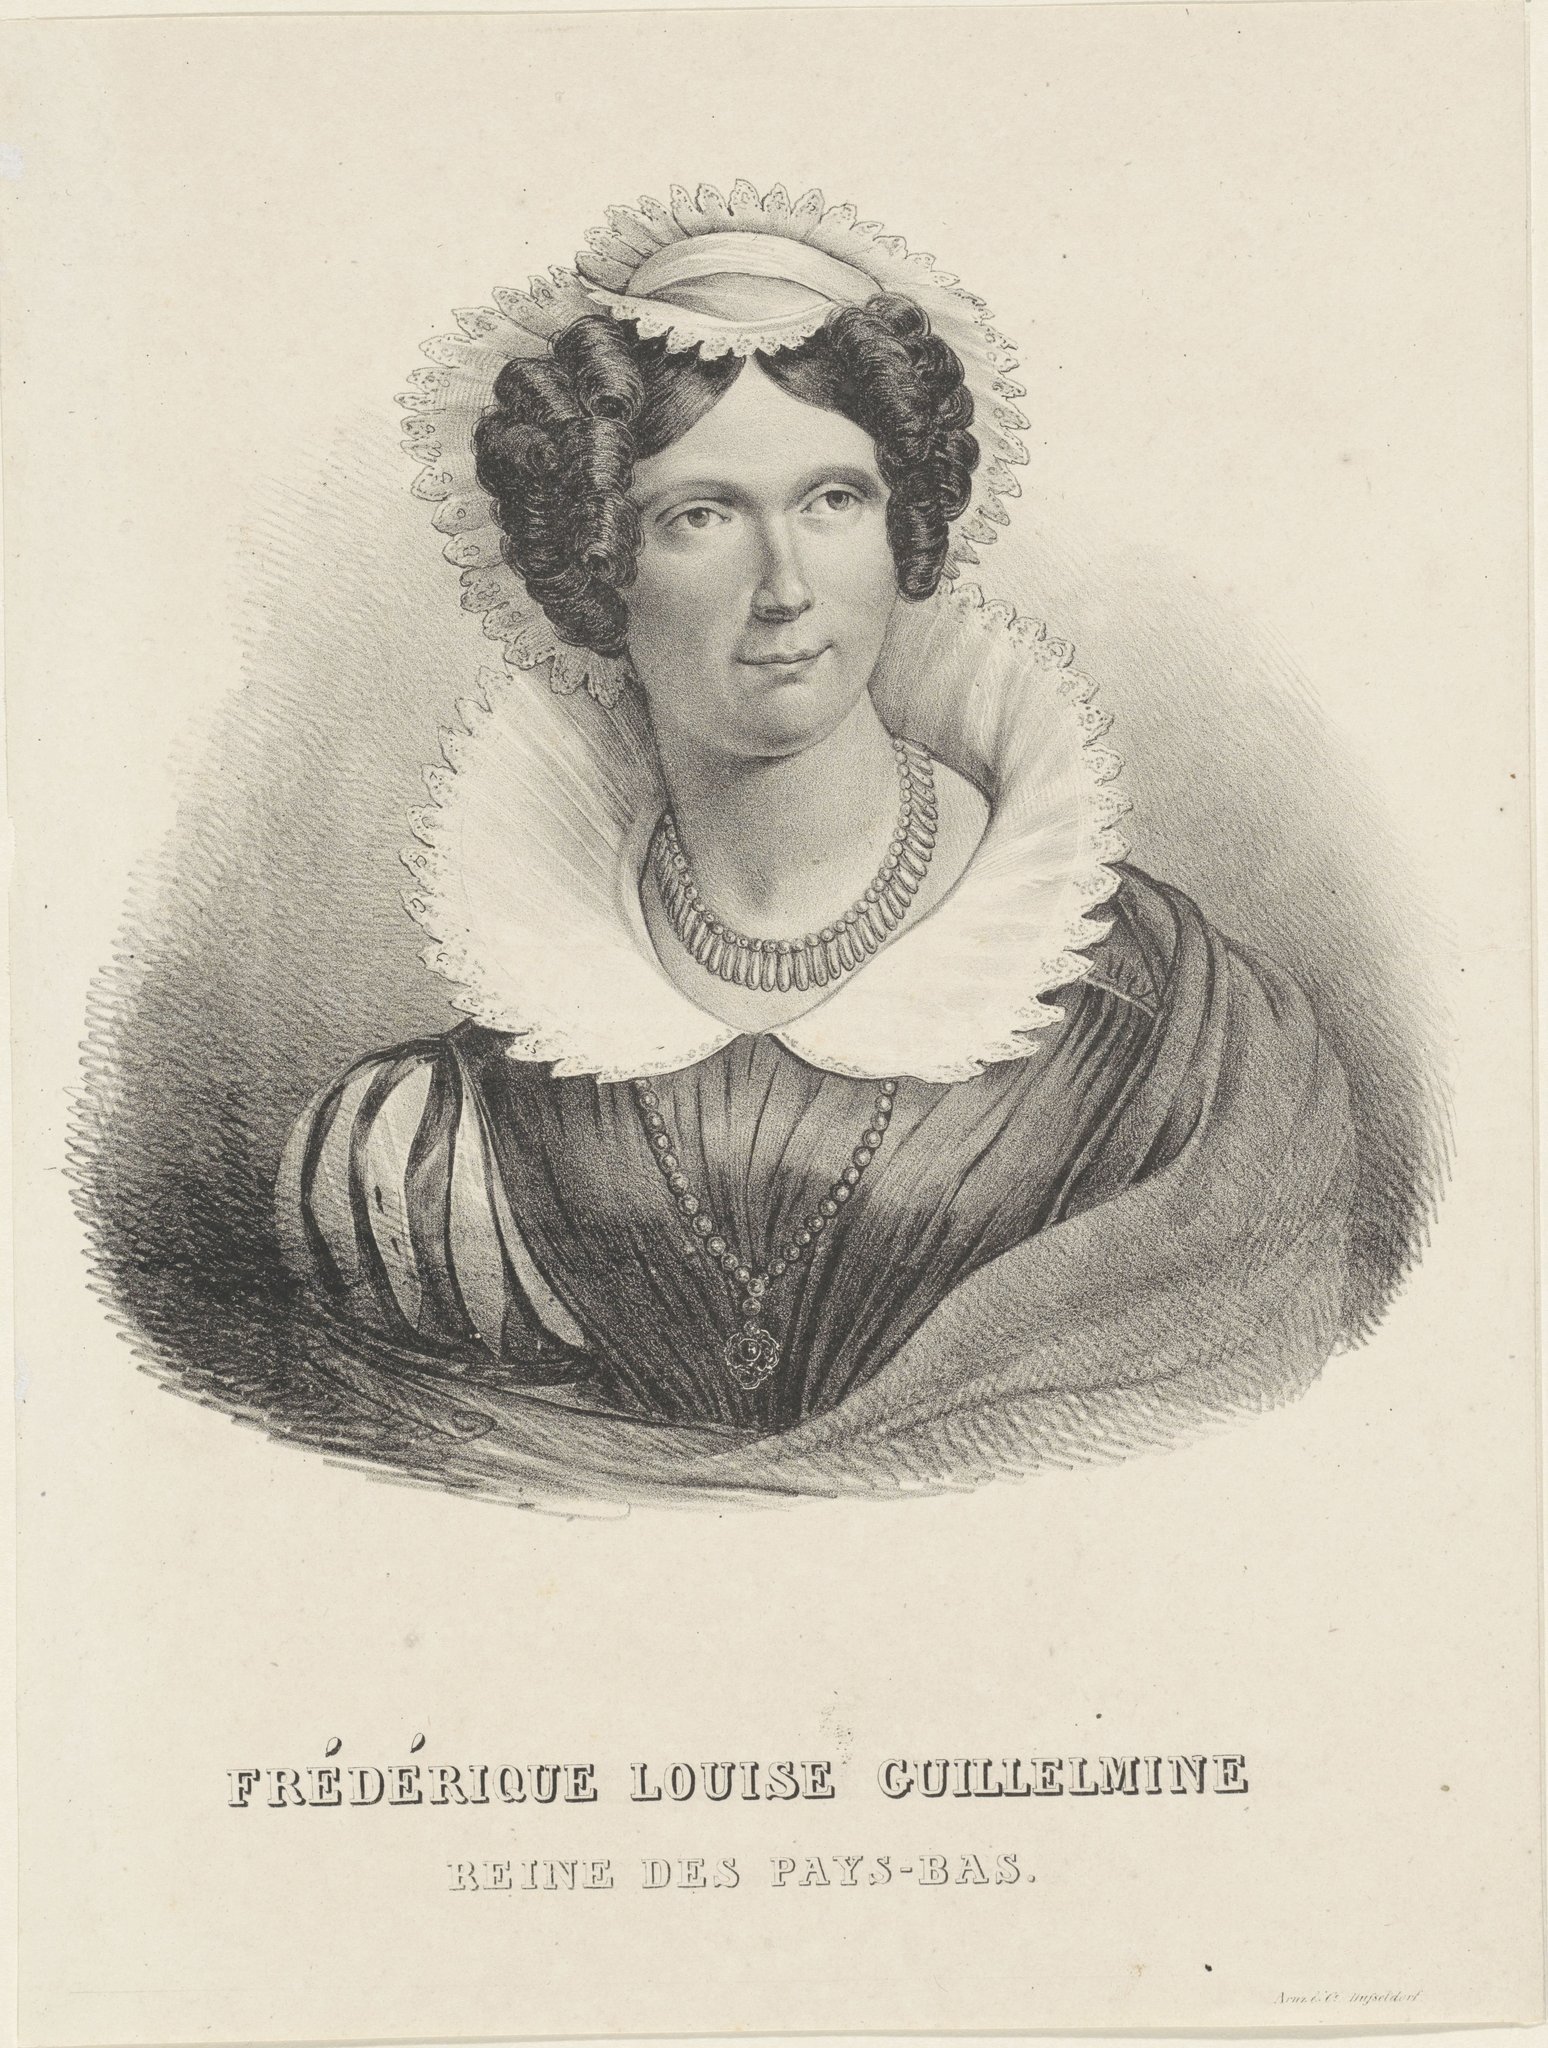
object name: print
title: Portret van Wilhelmina van Pruisen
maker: Anonymous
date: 1815-1899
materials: paper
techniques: lithograph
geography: netherlands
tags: berlin, wilhelmina frederica louisa (koningin der nederlanden)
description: Portret van Wilhelmina. In de ondermarge haar naam en titel.